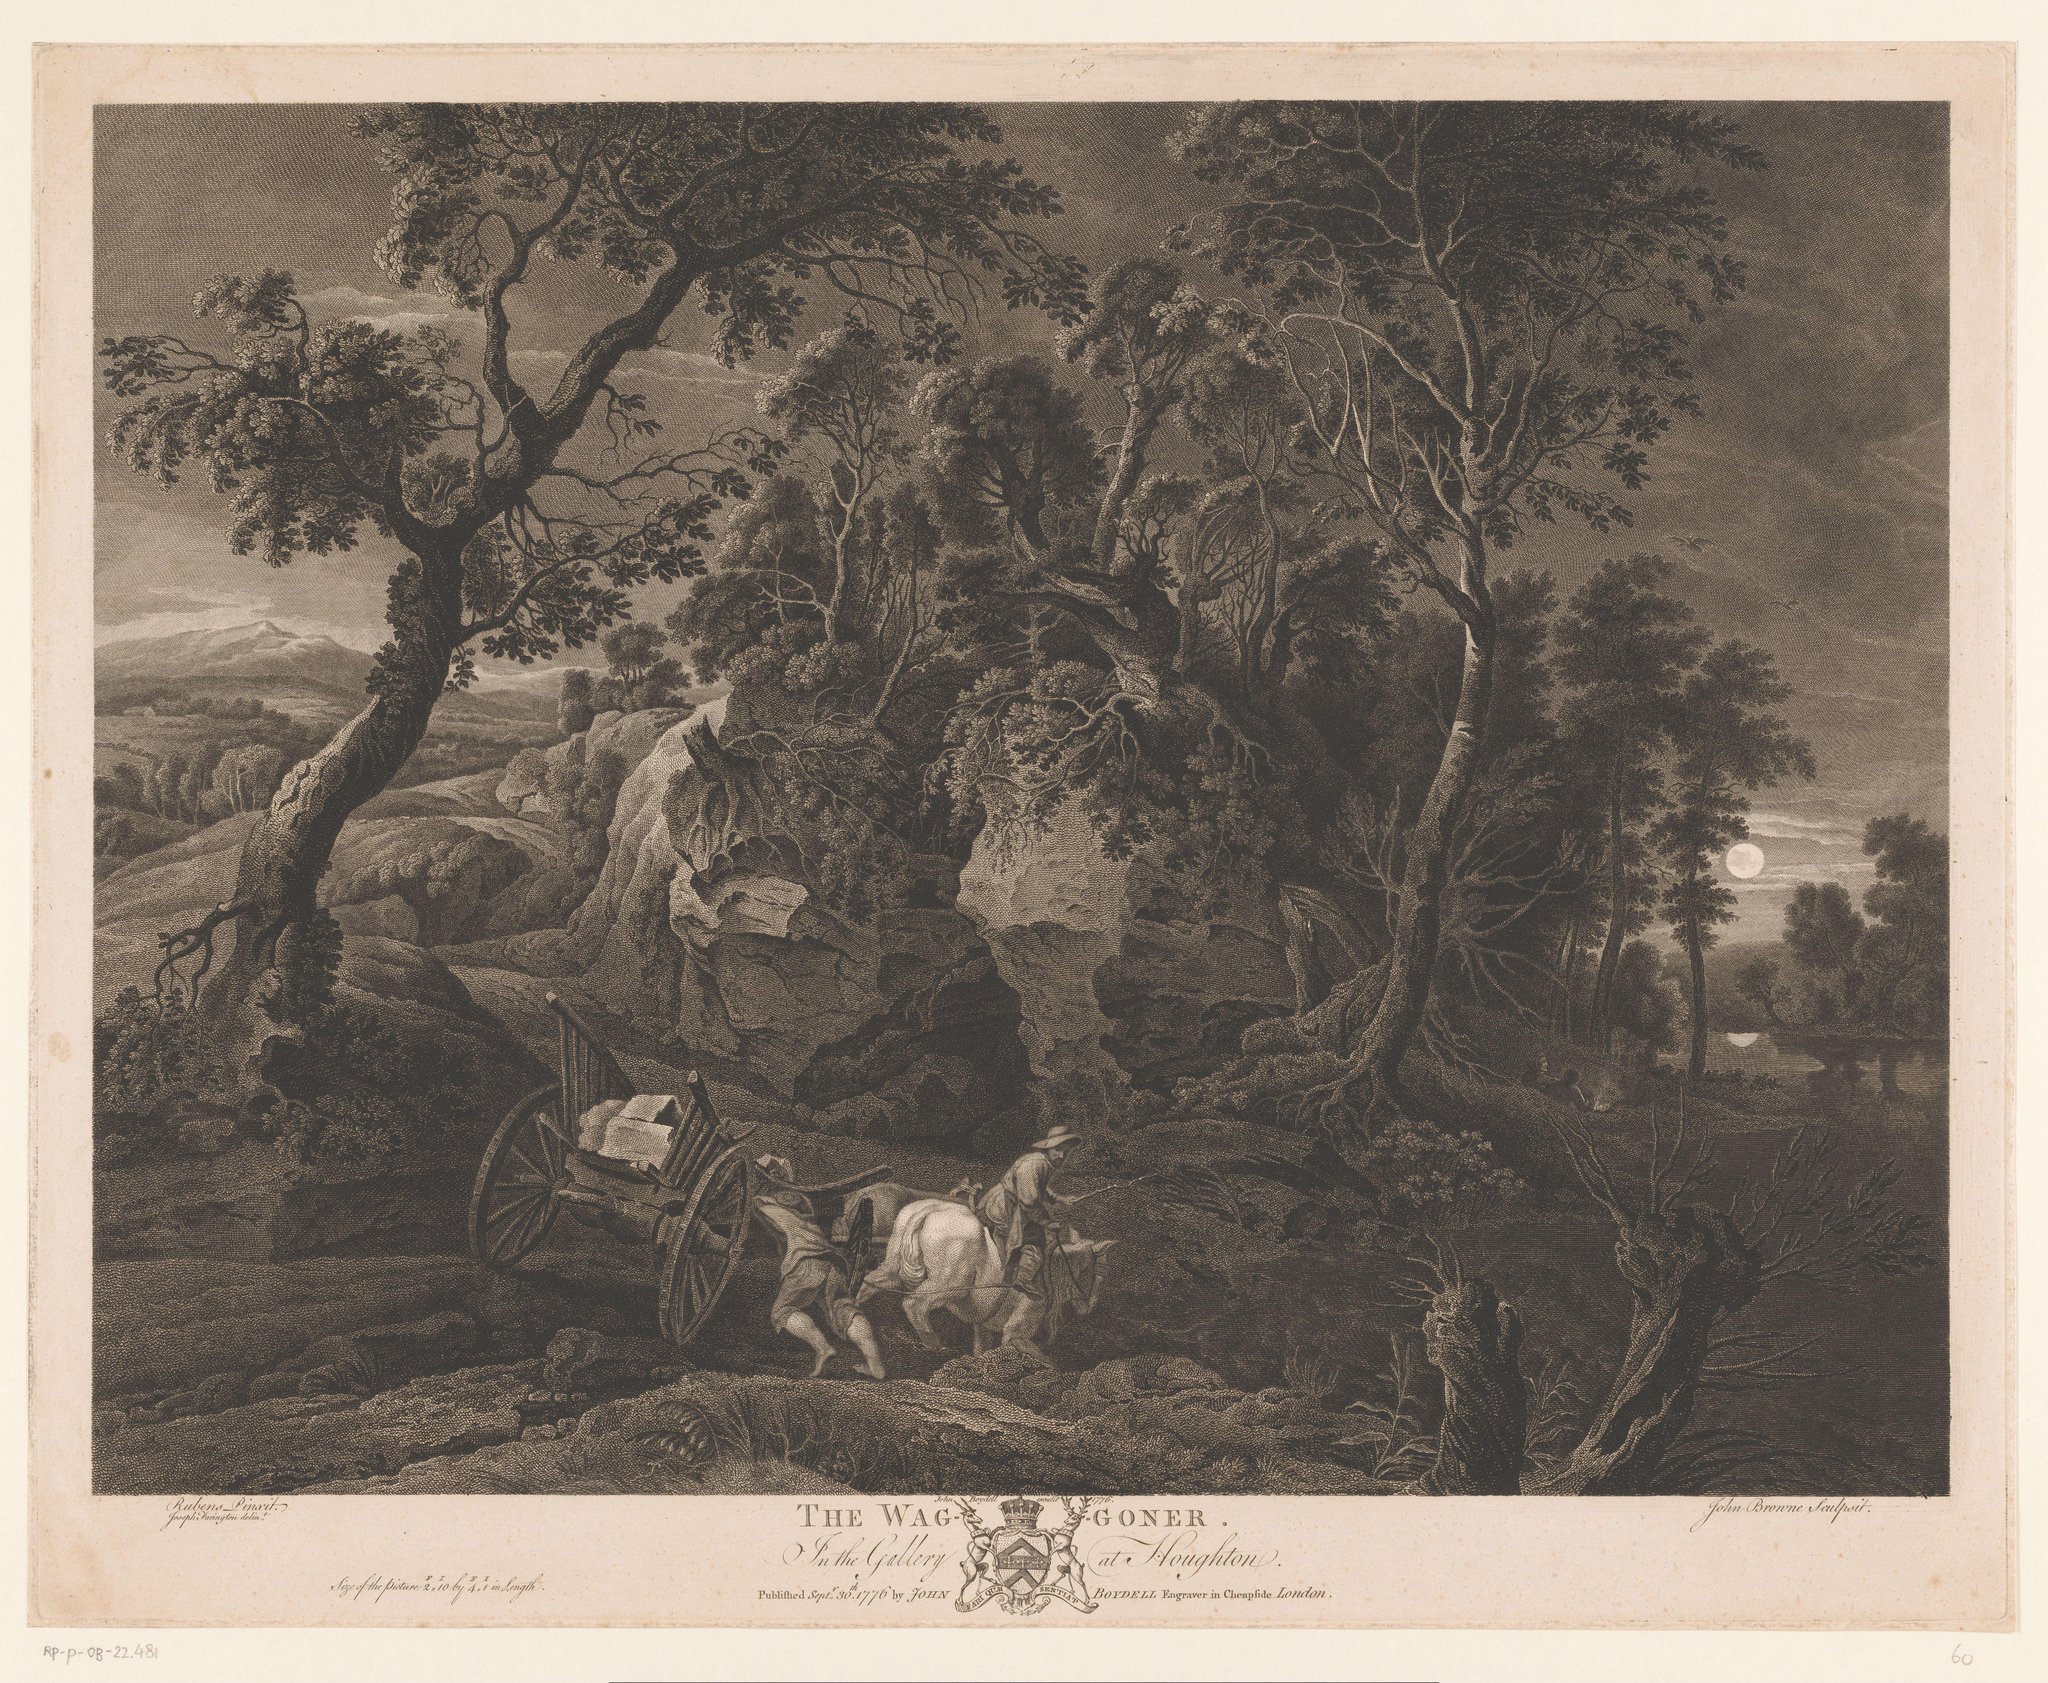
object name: print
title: The Waggoner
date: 1776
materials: paper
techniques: engraving, etching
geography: london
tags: low hill country (+ landscape with figures, staffage), night ~ landscape (sometimes titled 'nox'), rock-formations, (farm) wagon, freight wagon, cart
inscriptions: collector's mark: Lugt 12